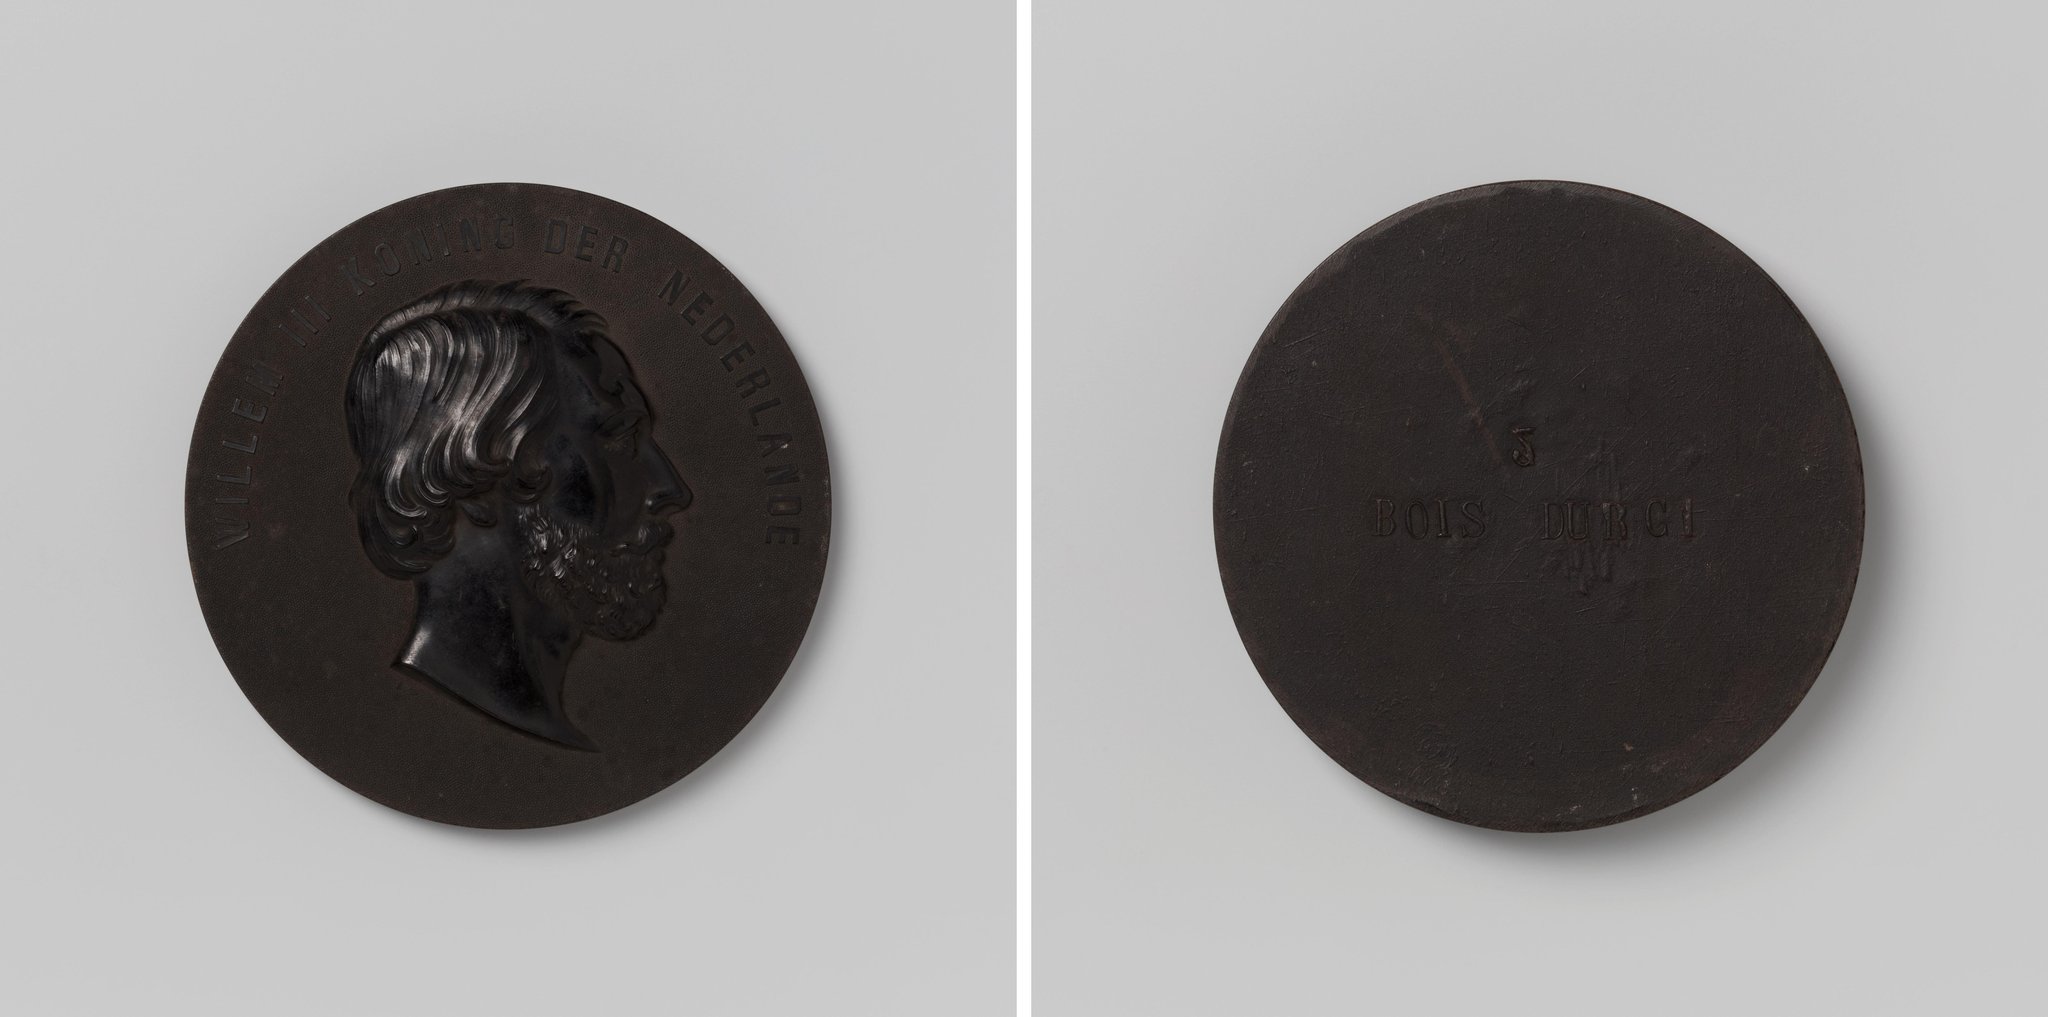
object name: plaque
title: Inhuldiging van Willem III als koning der Nederlanden te Amsterdam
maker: Anonymous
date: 1849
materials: wood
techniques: cutting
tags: brussels, willem iii (koning der nederlanden), amsterdam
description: Voorzijde: borststuk man naar rechts binnen omschrift; onder armafsnede merktekentje: vleugeltje. Keerzijde: opschrift